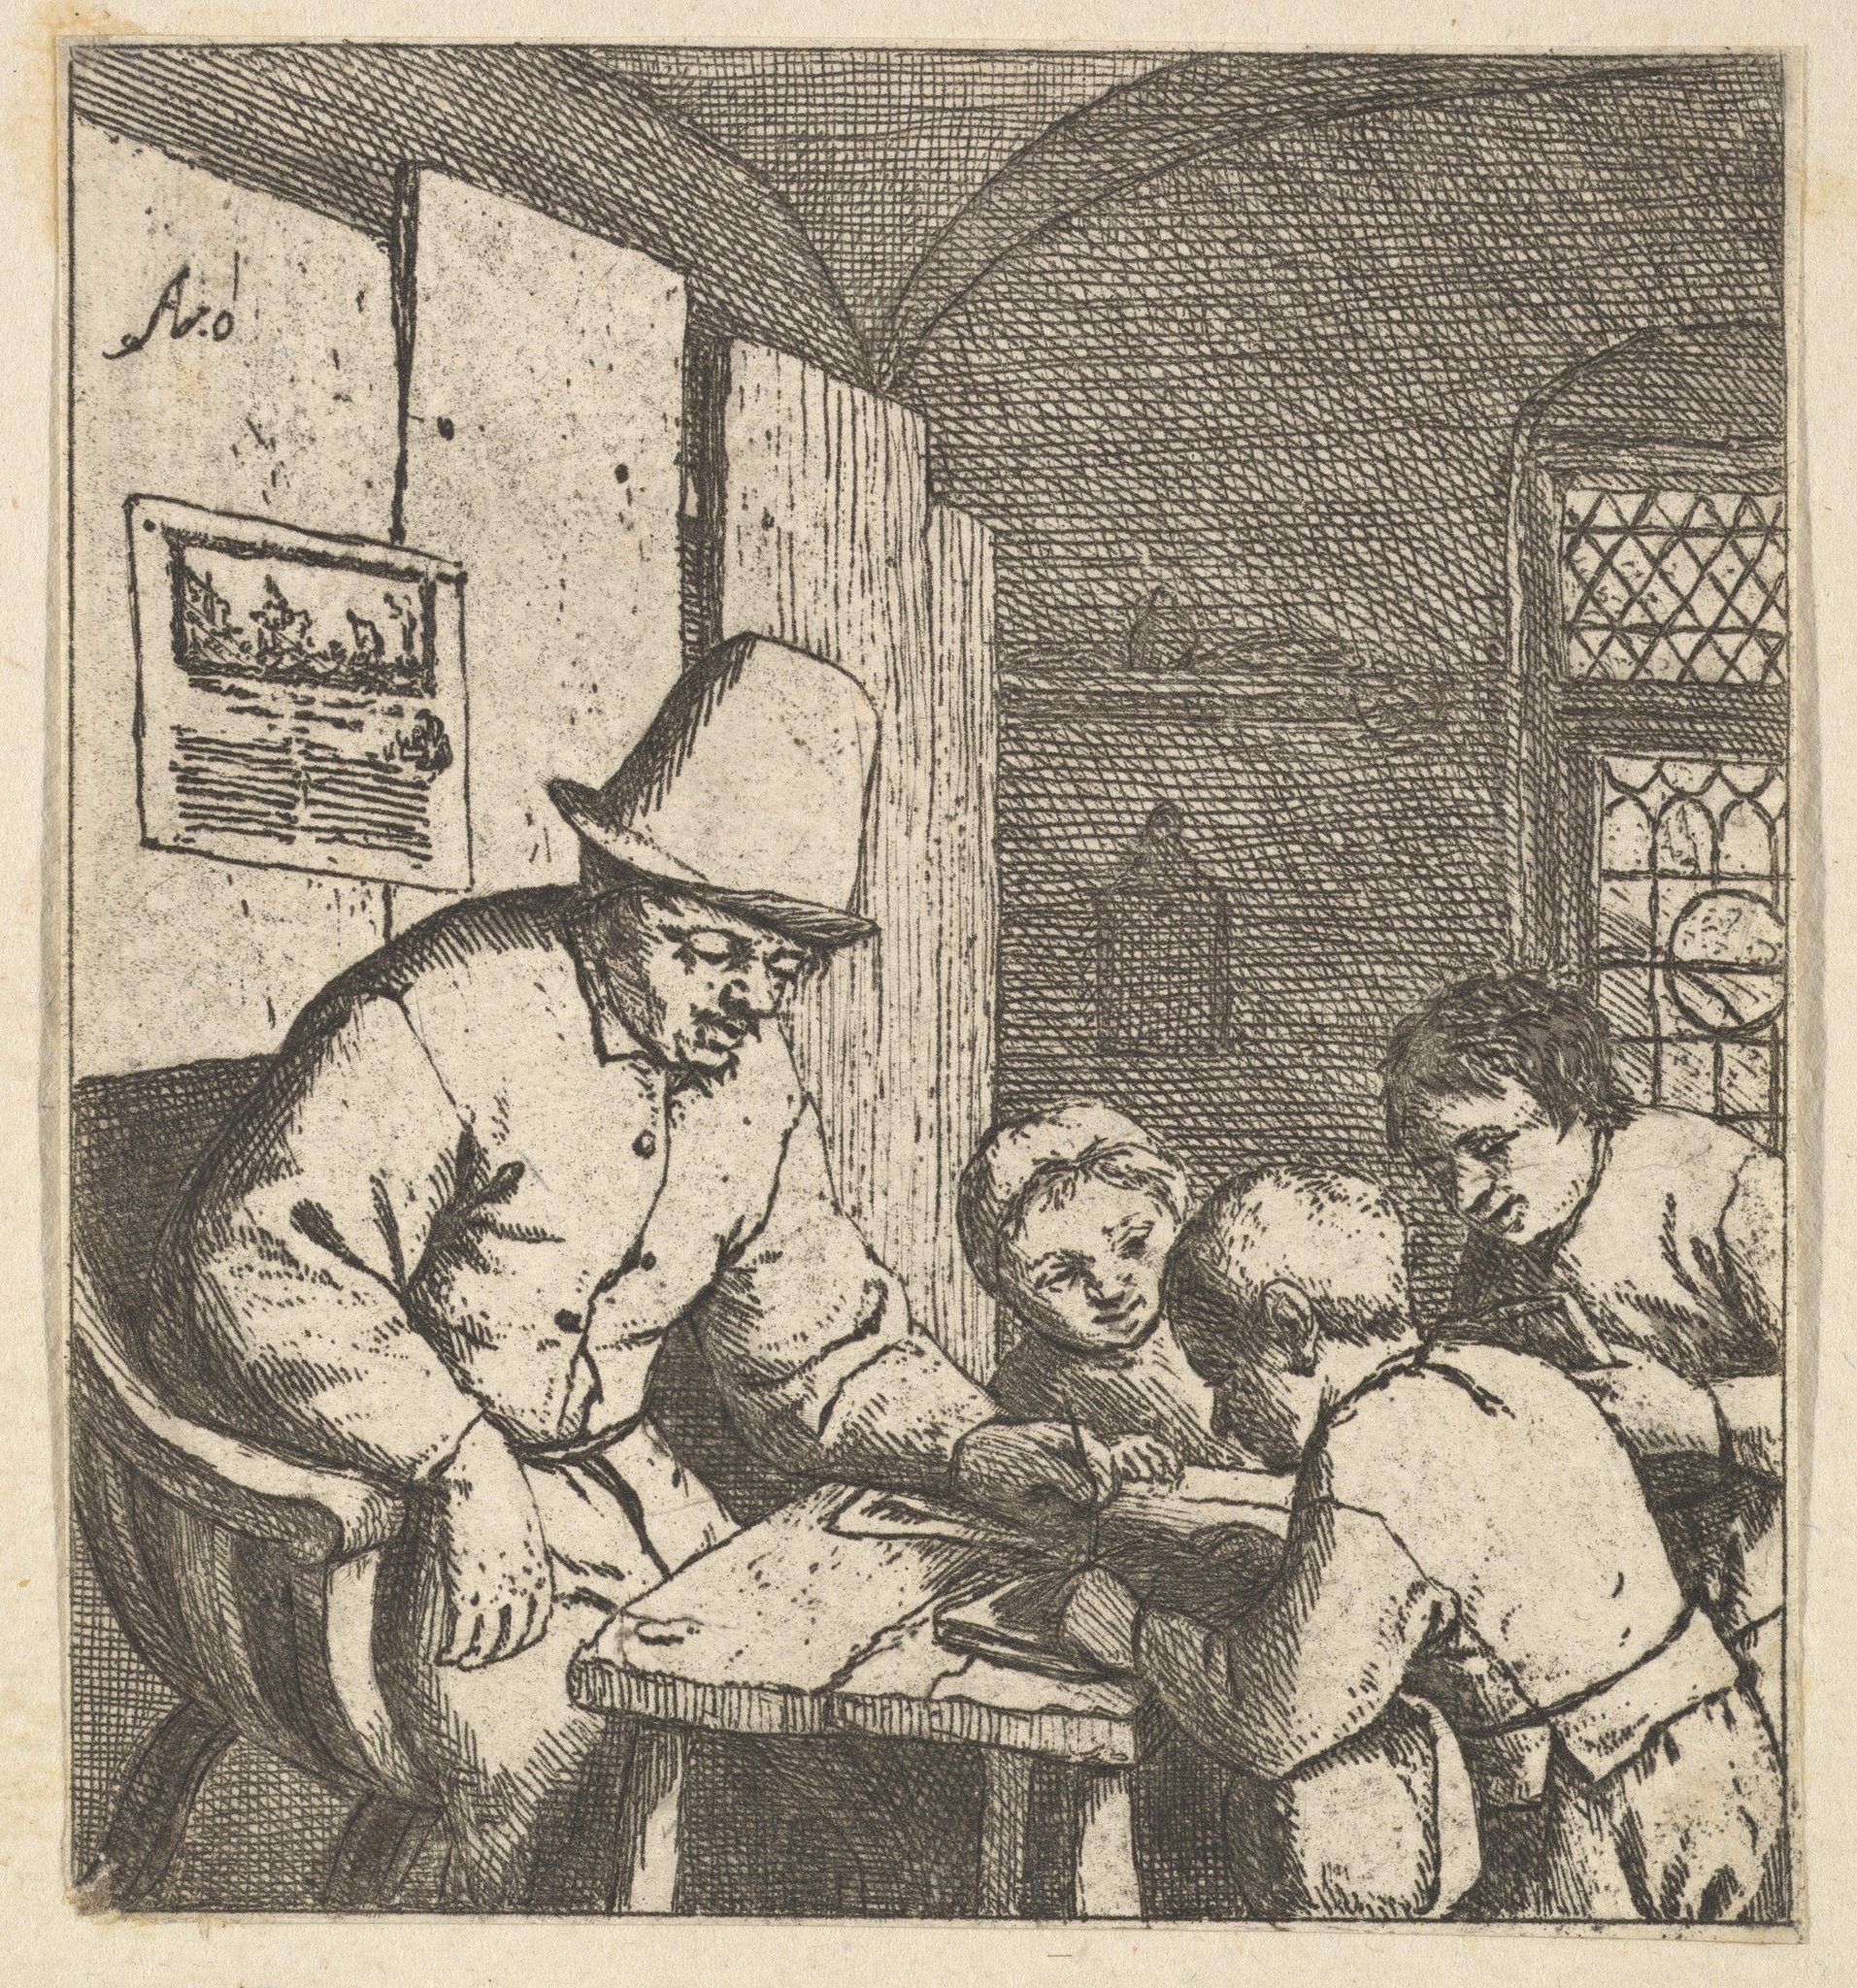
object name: print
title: The Schoolmaster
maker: adriaen van ostade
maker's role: artist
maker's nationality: dutch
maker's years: 1610-1685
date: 1610-1685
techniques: etching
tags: students,teachers